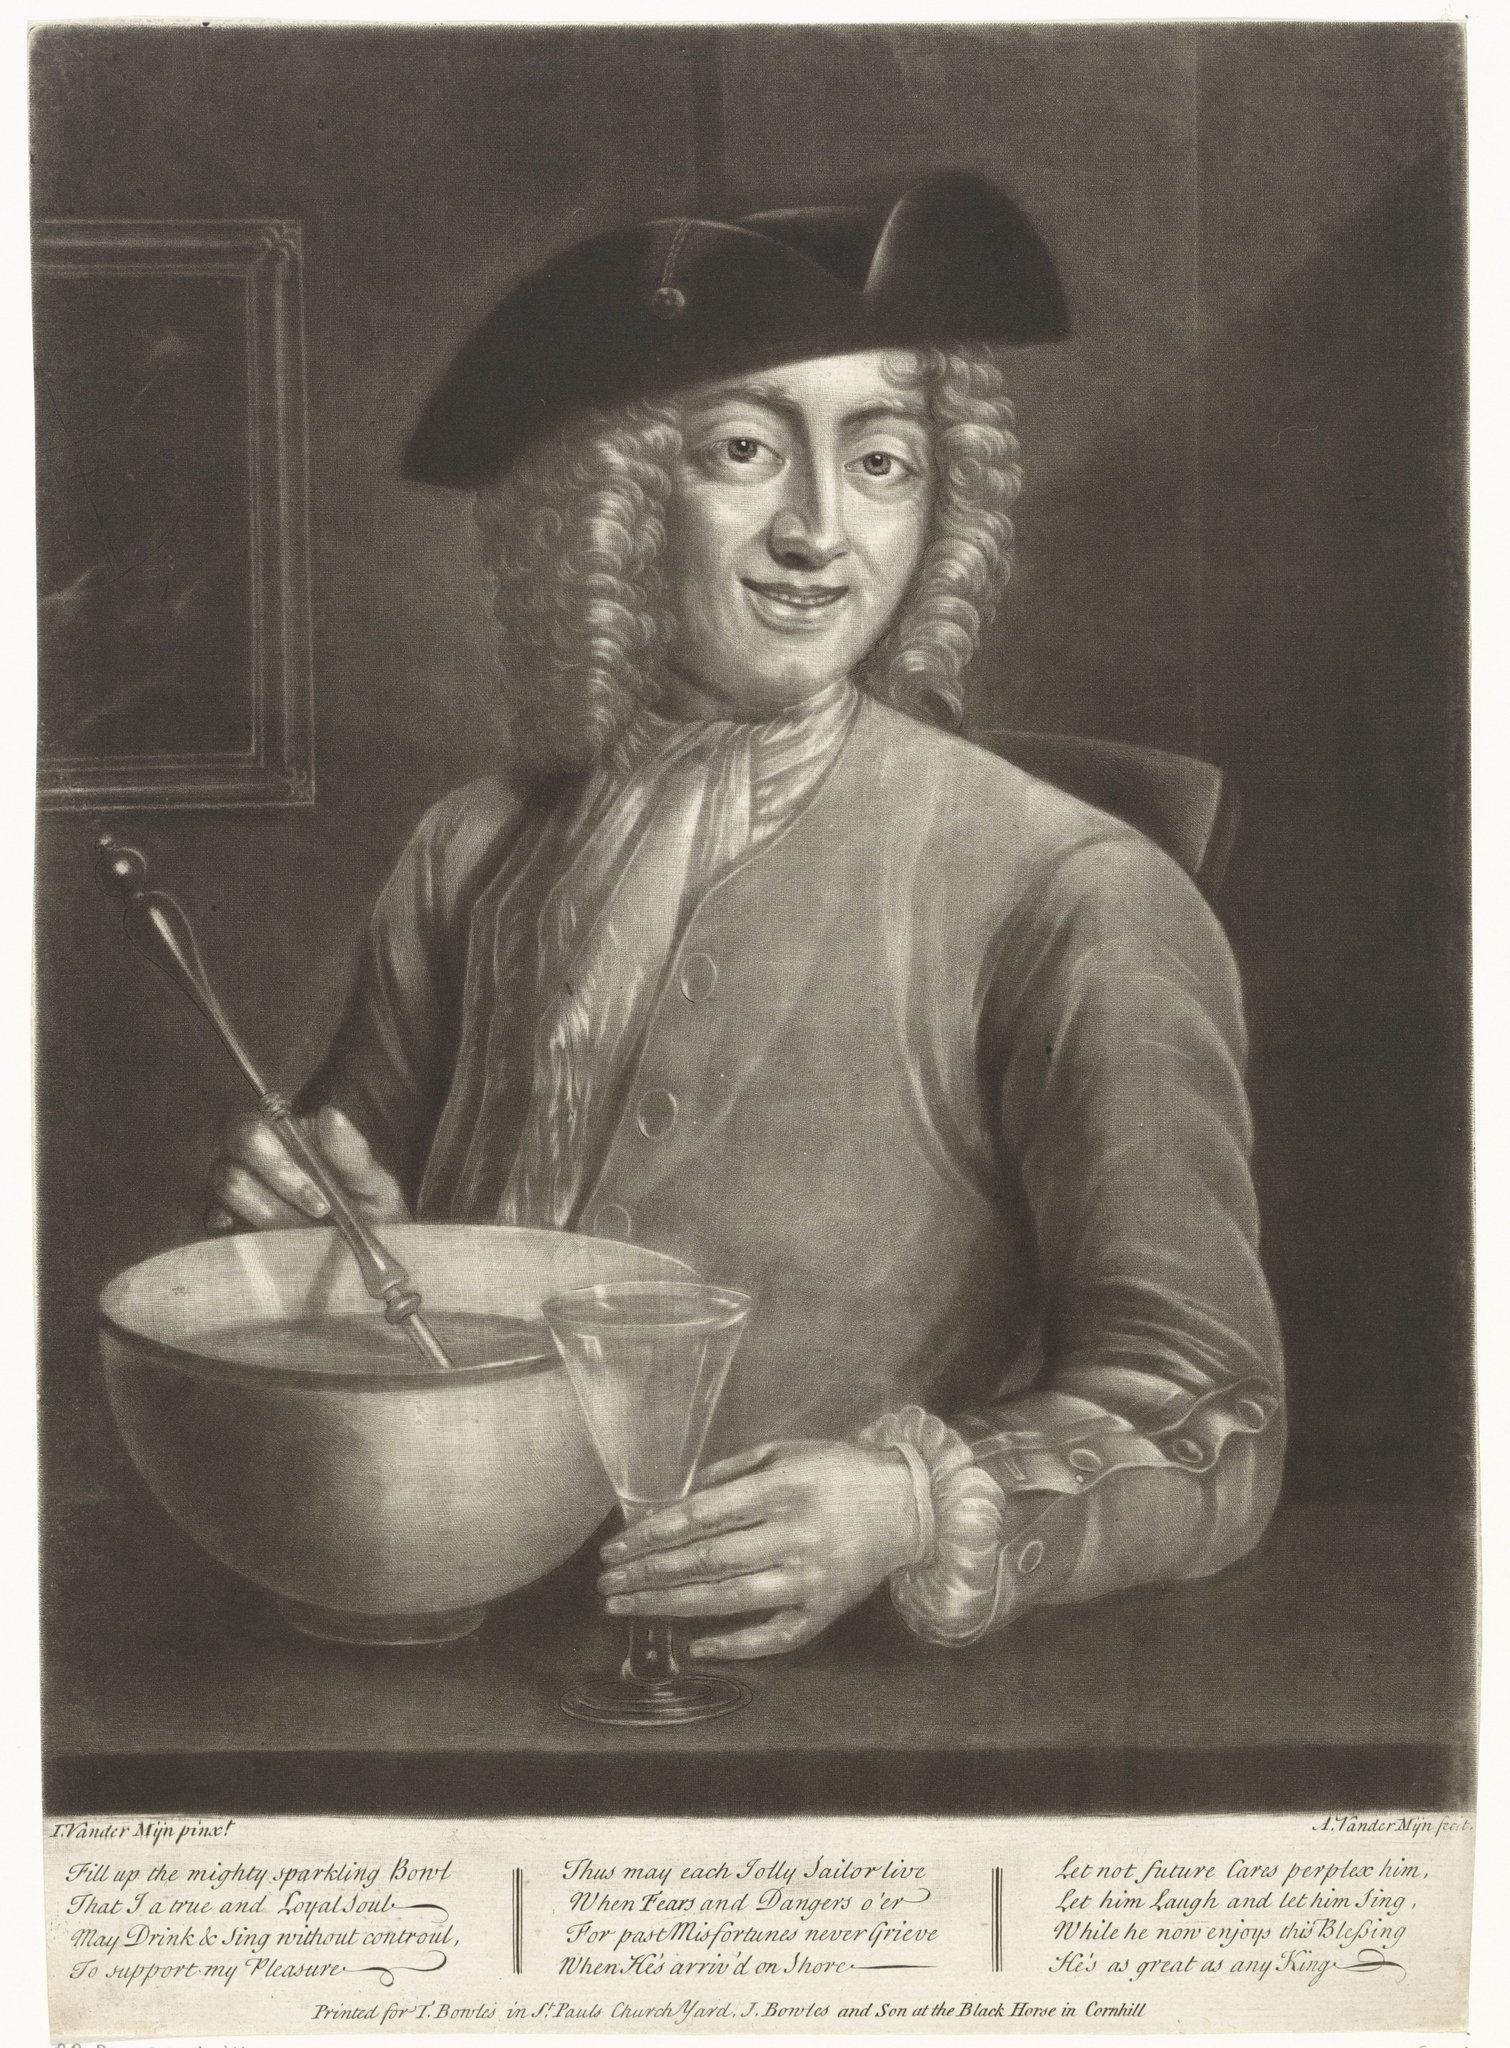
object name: print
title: Man met een glas en een schaal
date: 1724-1800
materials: paper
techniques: engraving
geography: england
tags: head-gear: hat (+ men's clothes), picture, painting, drinking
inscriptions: :, collector's mark: Lugt 2228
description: Een man zit aan een tafel, voor hem staan een glas en een schaal. Hij staat op het punt om zijn glas te vullen met drank. Aan de muur hangt een schilderij.